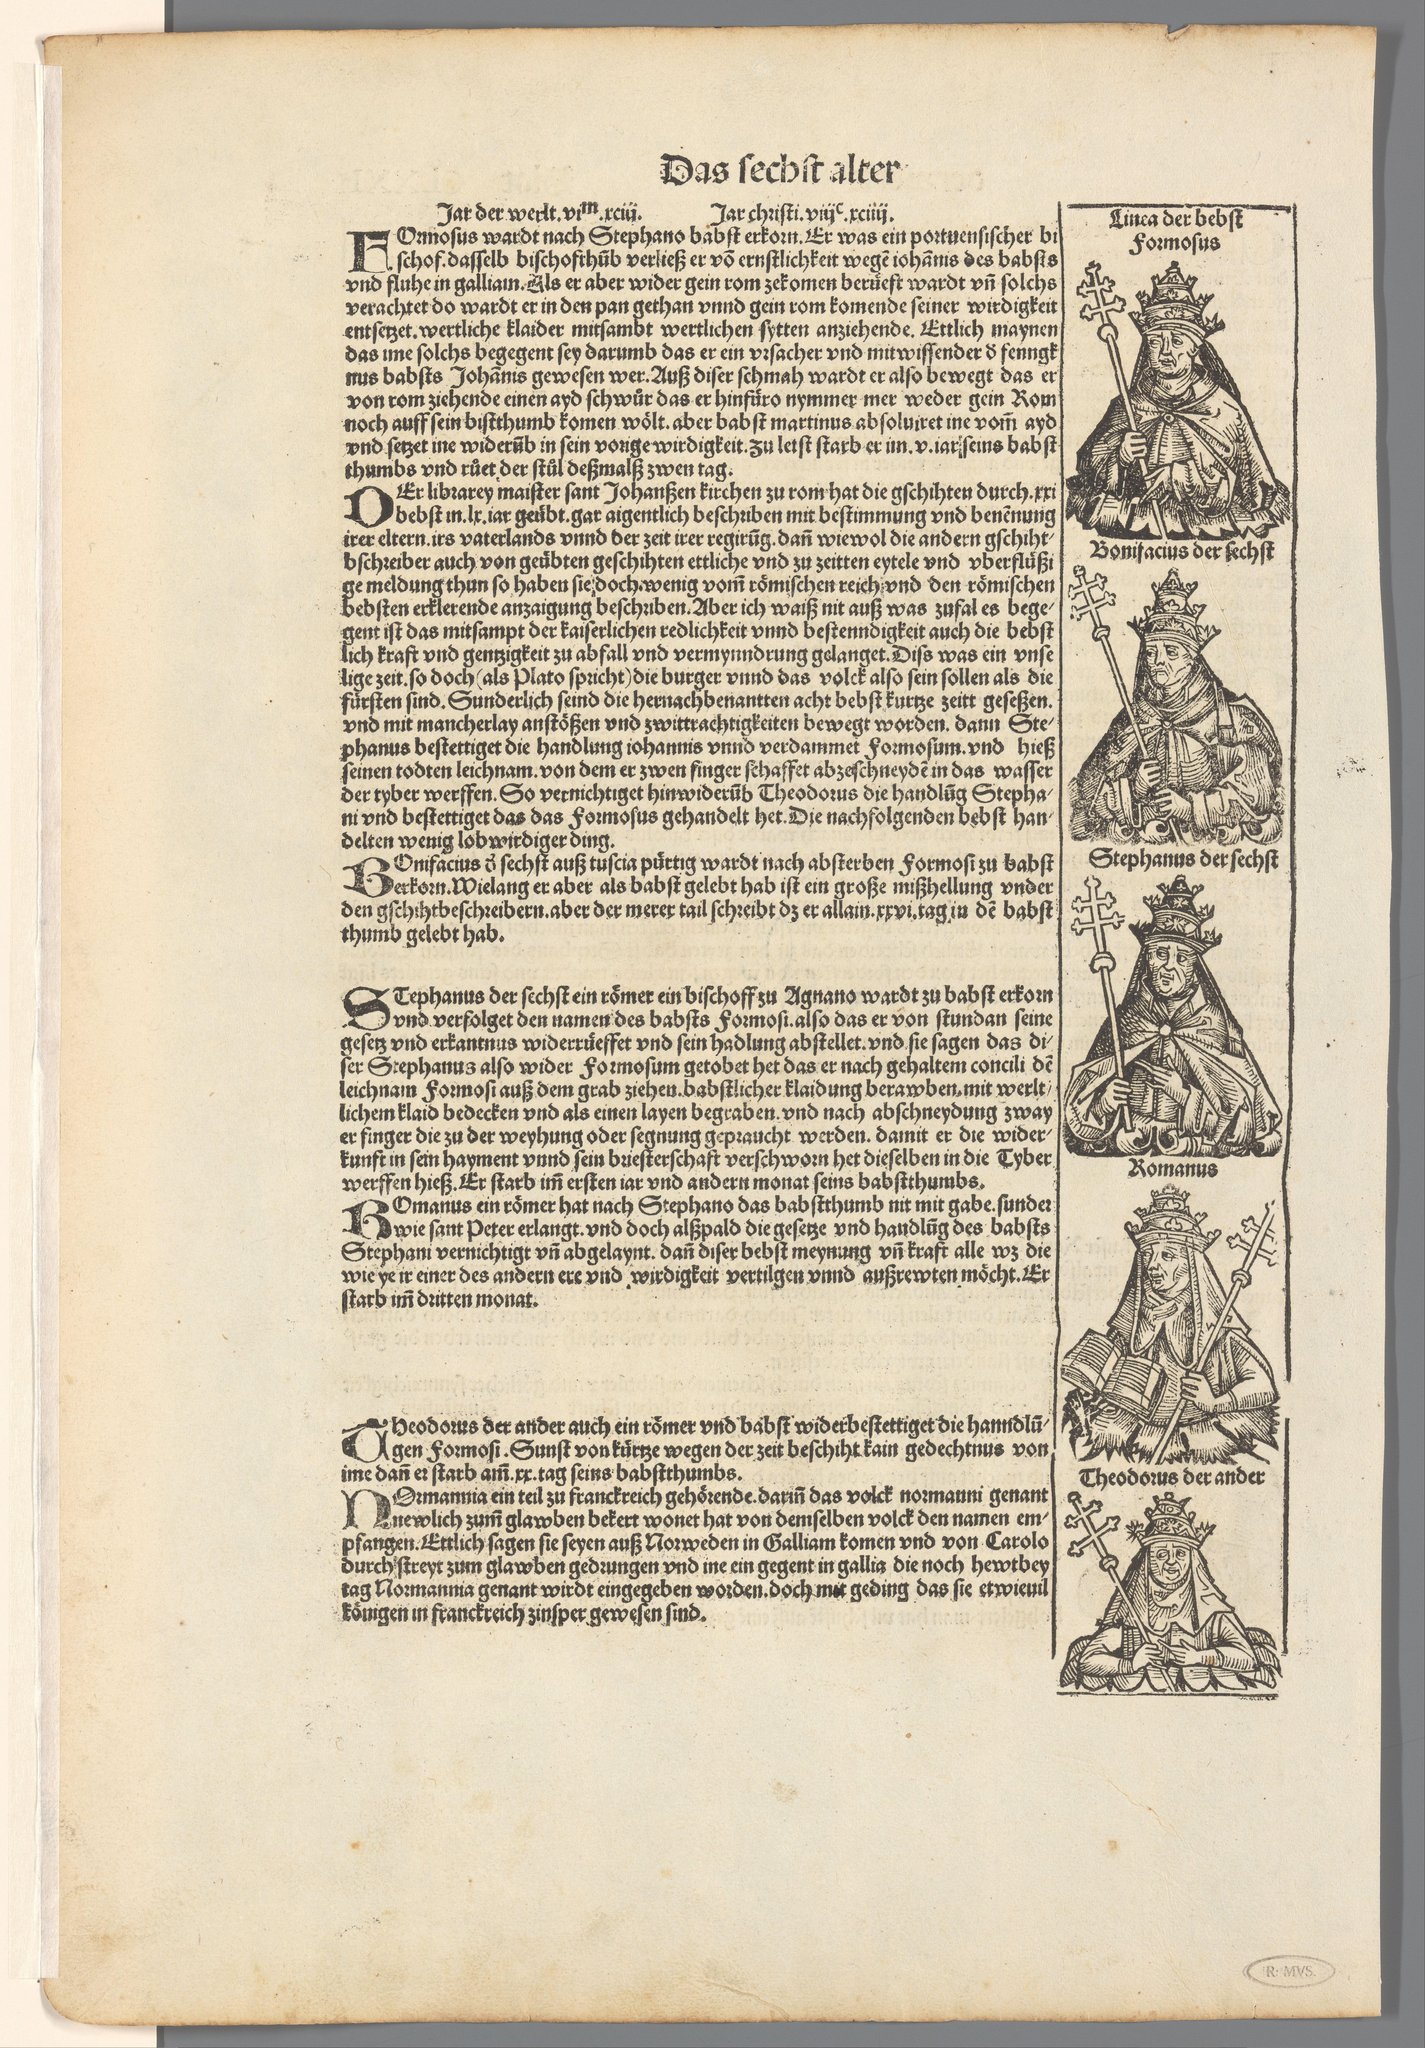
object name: print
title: Bladzijde uit de Neurenbergkroniek van Schedel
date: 1493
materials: paper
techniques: woodcut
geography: nuremberg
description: Afkomstig uit: Schedel, Hartmann. Die Schedelsche Weltchronik. Neurenberg: Anton Koberger, 1493.